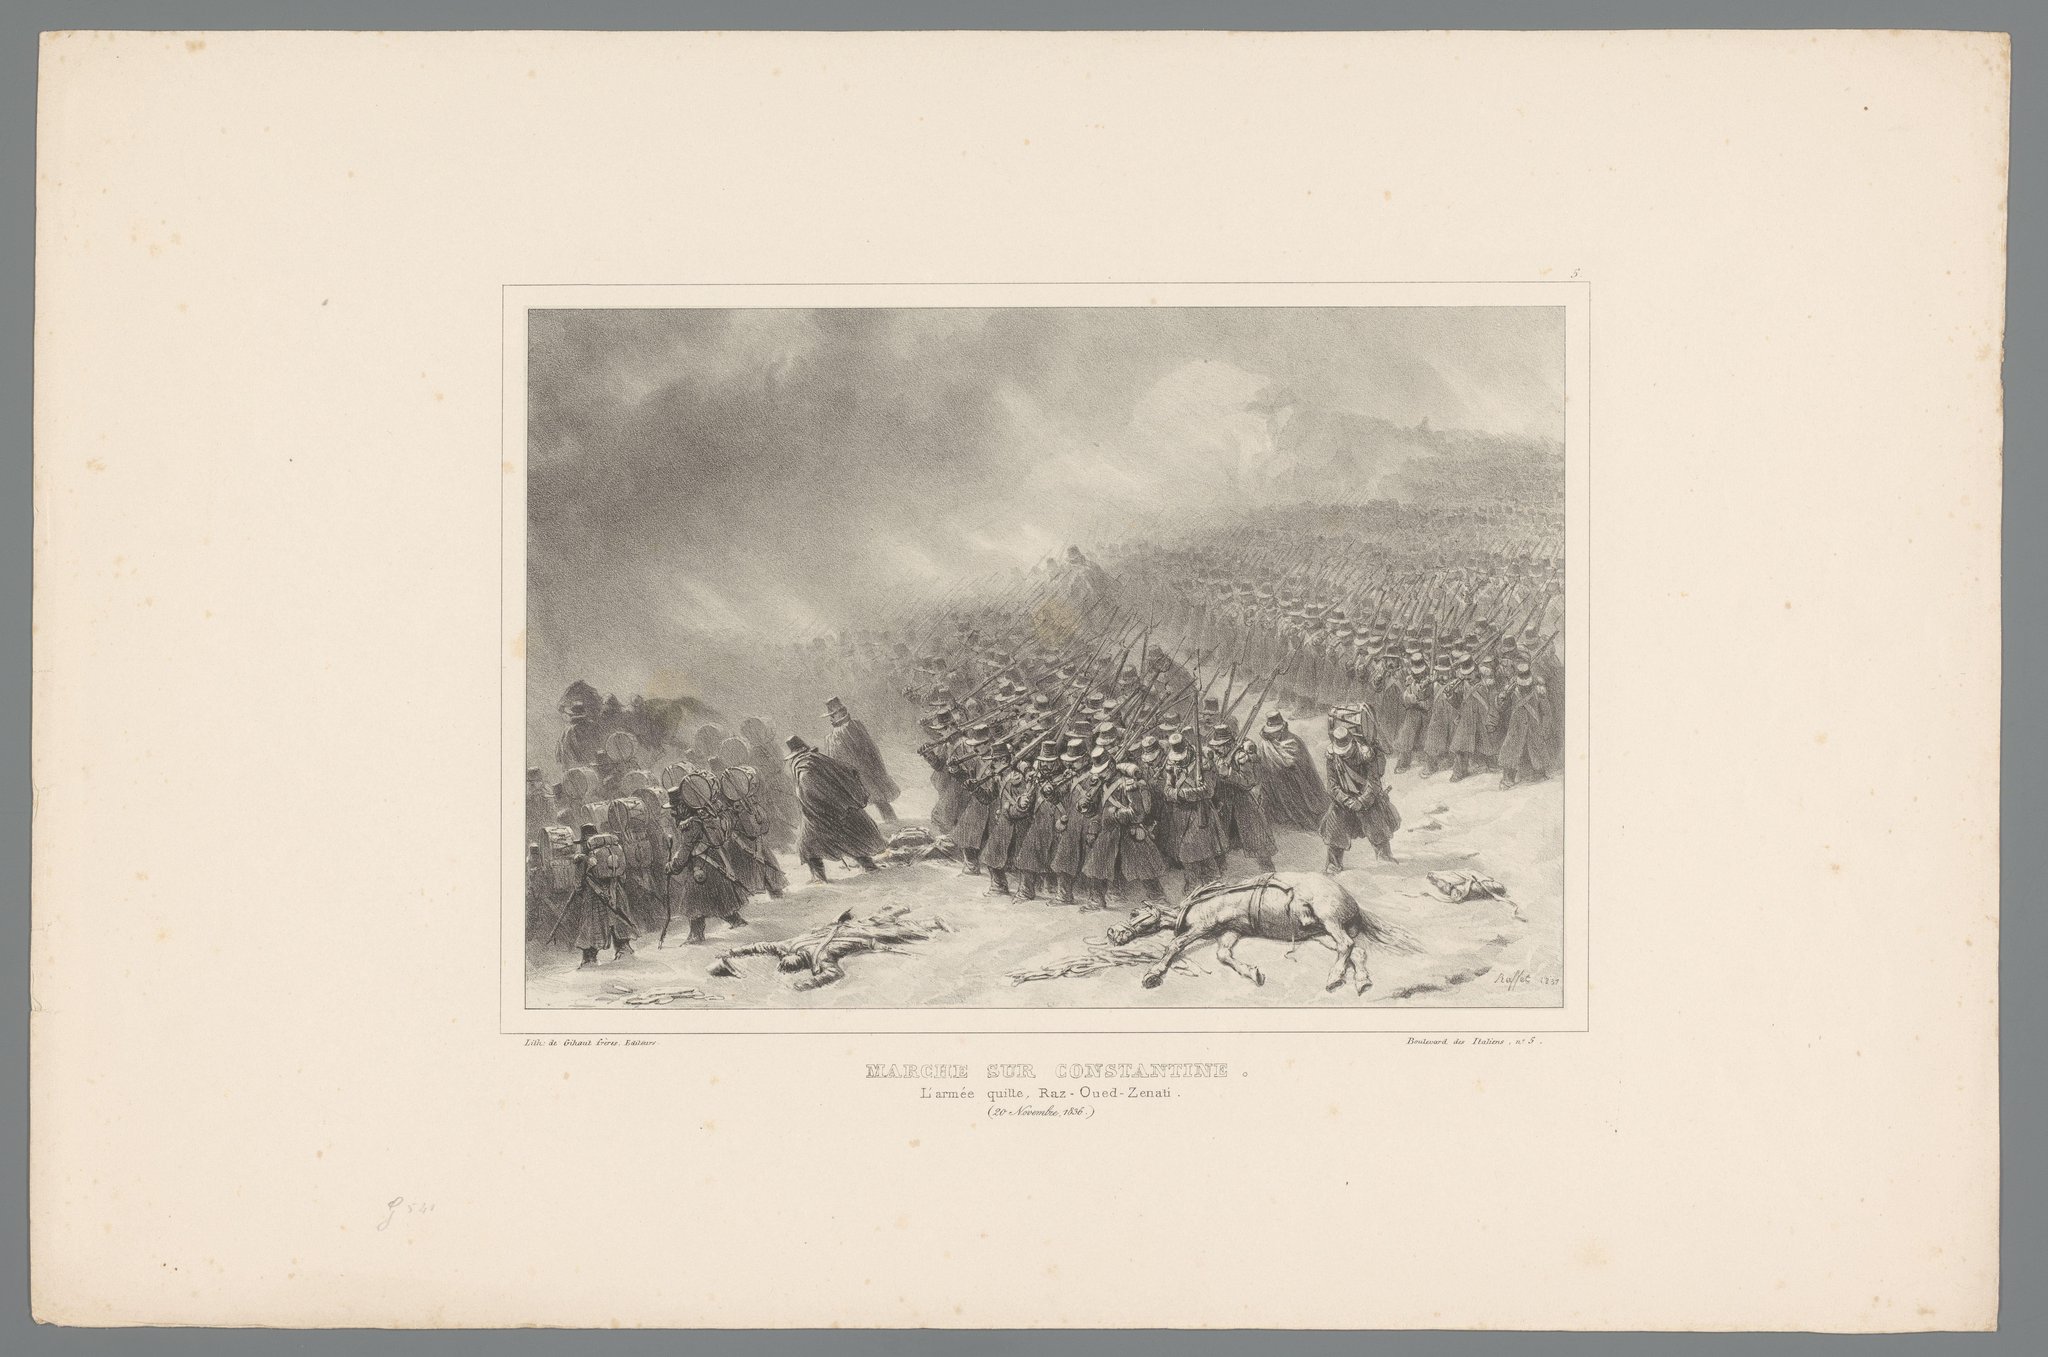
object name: print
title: Marche sur Constantine (...) (20 novembre 1836)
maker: denis auguste marie raffet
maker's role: draughtsman, print maker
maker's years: 1804-1860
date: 1837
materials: paper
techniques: lithograph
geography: paris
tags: the soldier; the soldier's life, retreat of the defeated, division of armed forces, the defeated (after the battle)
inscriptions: collector's mark: Lugt 2228